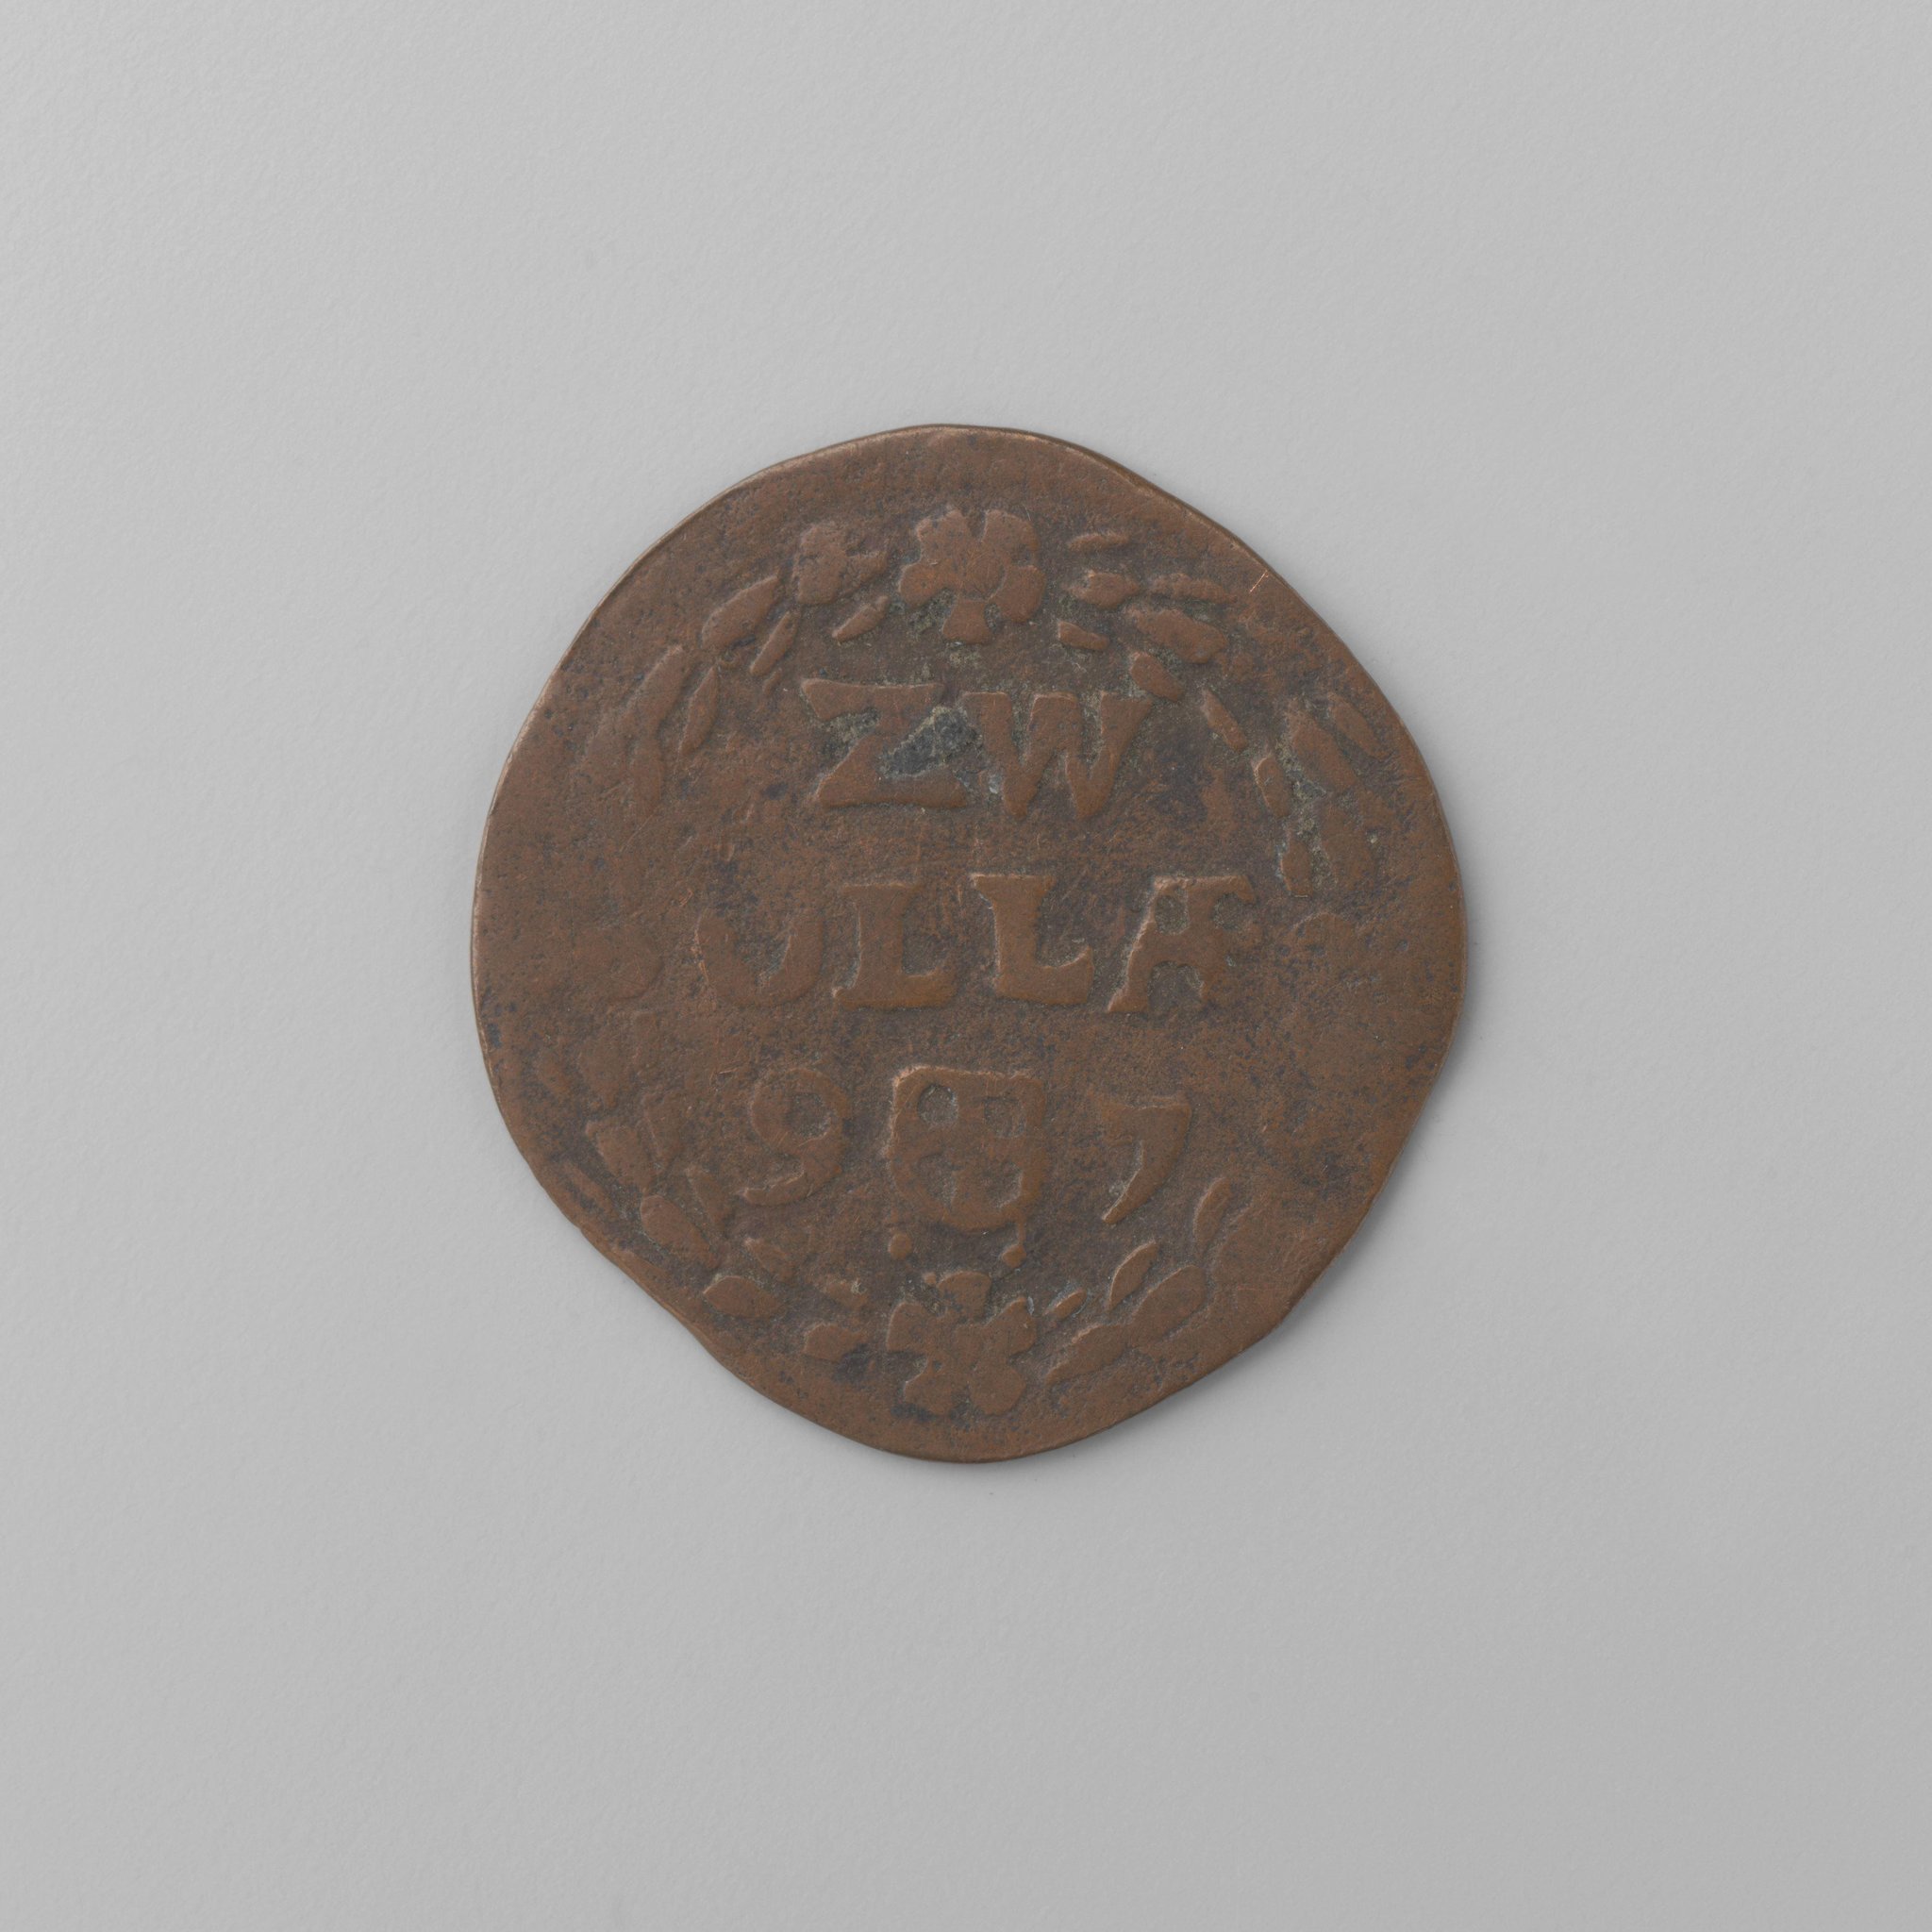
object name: coin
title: Driebutken van de Drie Steden, 1560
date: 1560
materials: silver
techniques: striking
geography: deventer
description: Zilveren munt. Voorzijde: ingesneden wapenschild van Kampen op lang versierd kruis. Jaartal 60 in omschrift. Keerzijde: ingesneden wapenschilden van de Drie Steden, in het centrum letter C.